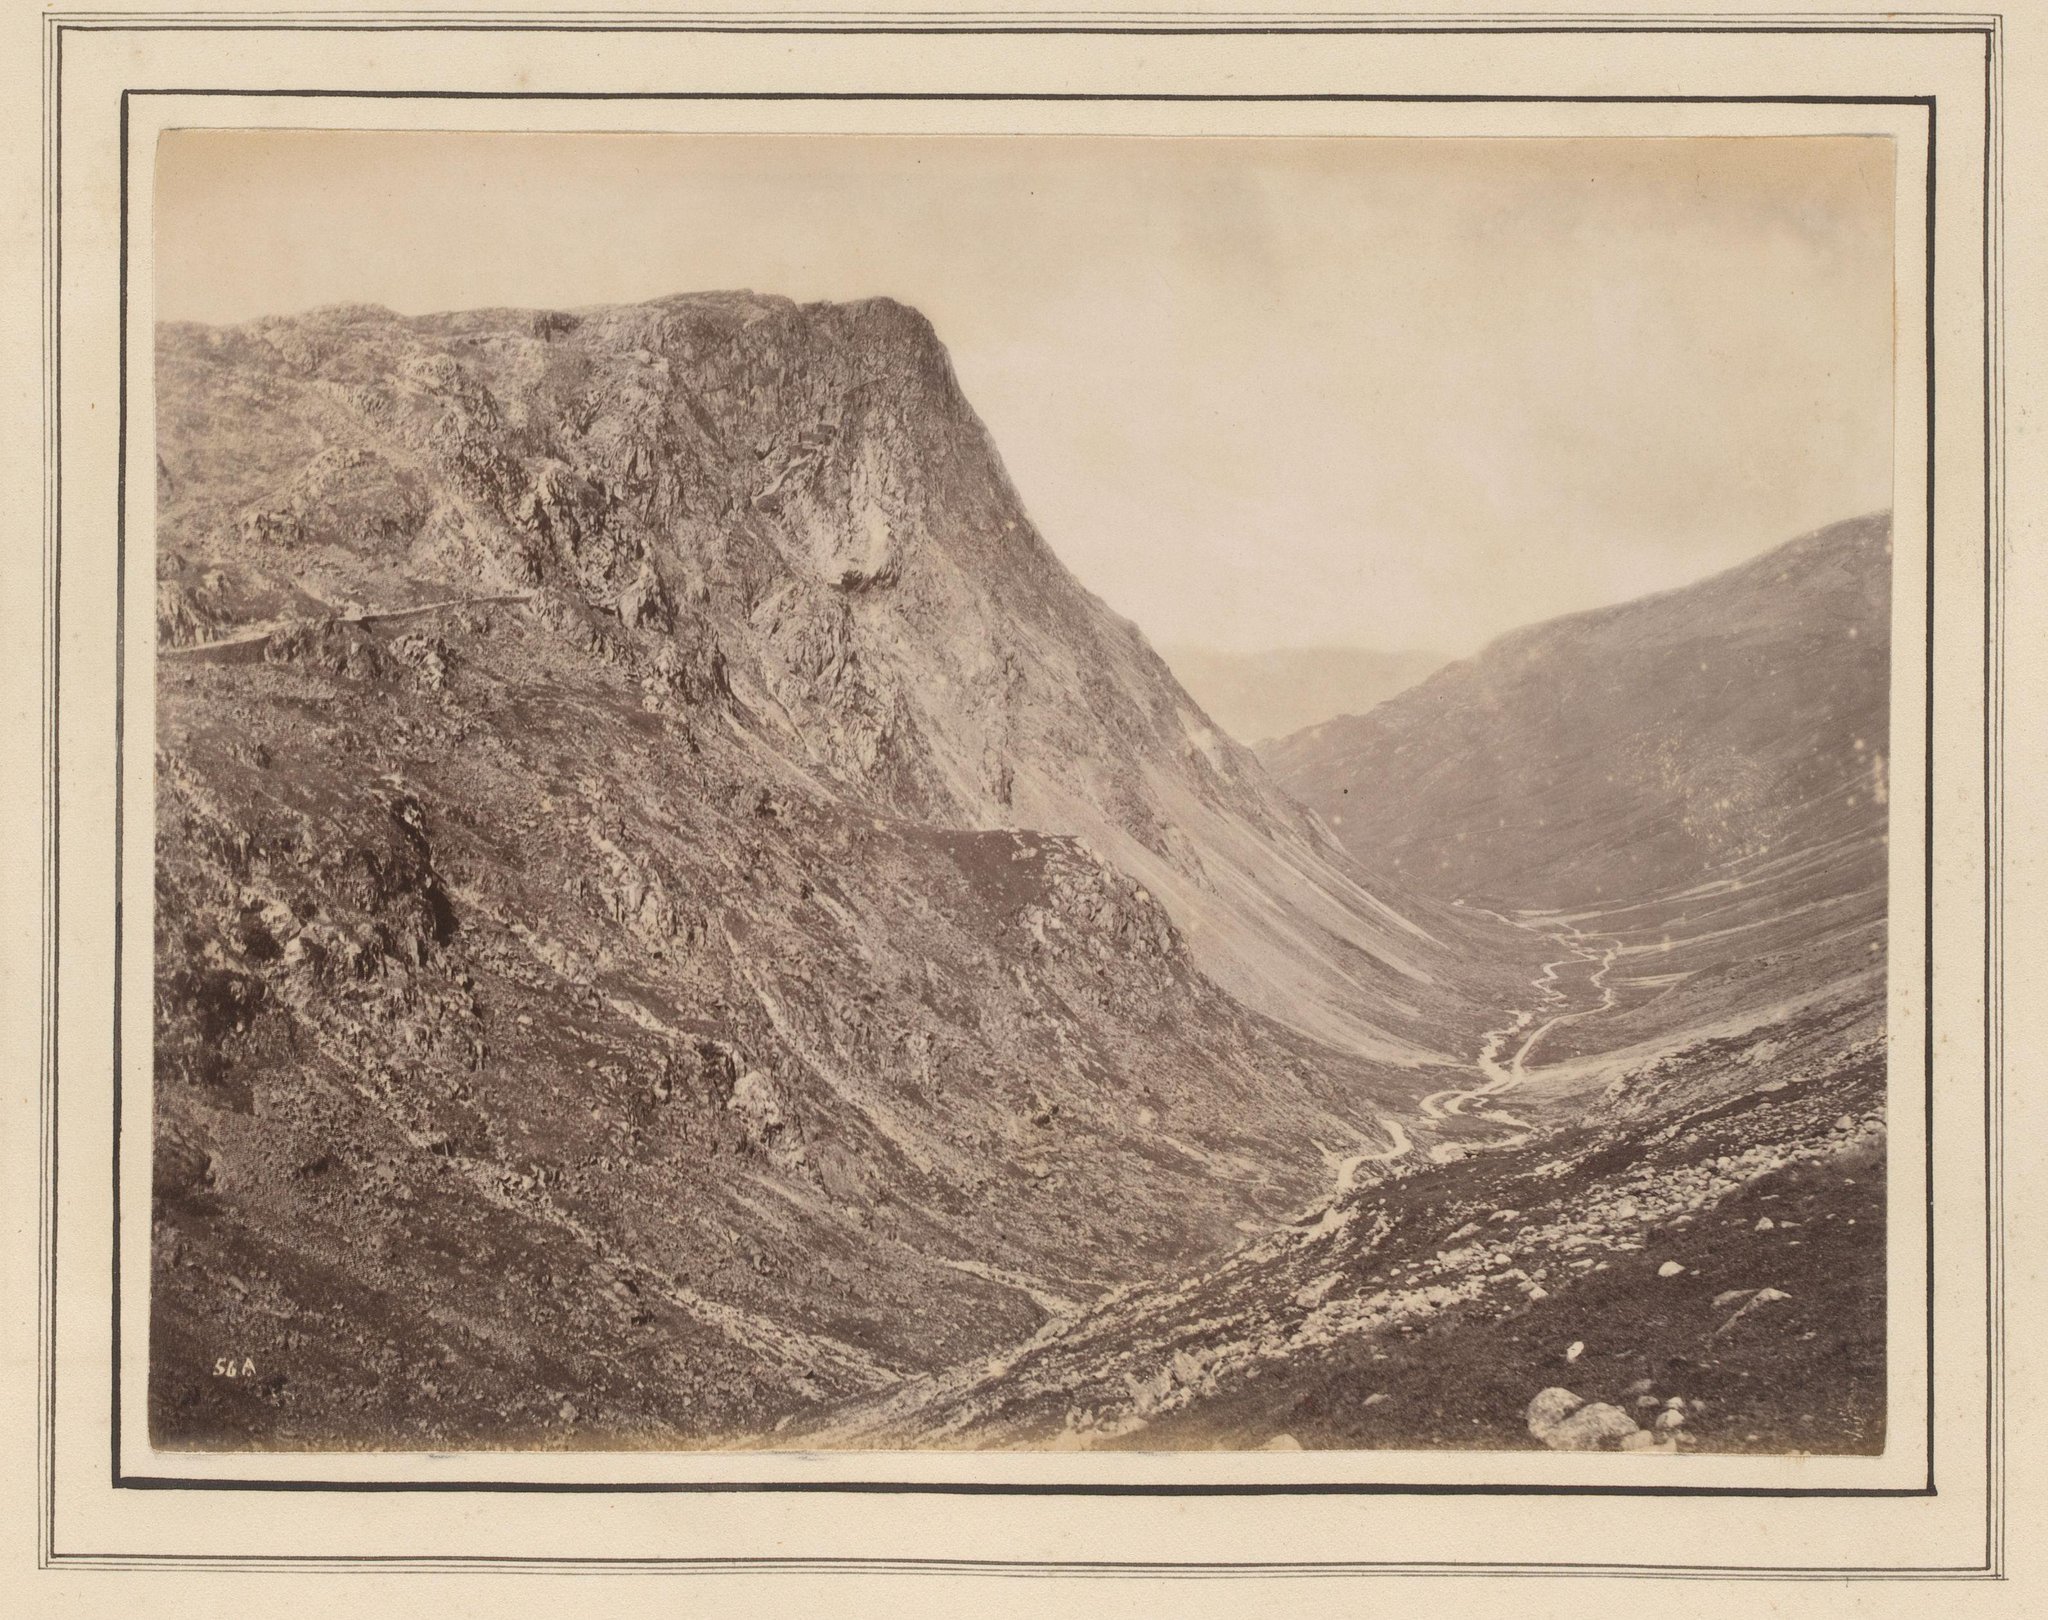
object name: photograph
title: Lakes of England. Honester Pass.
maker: Anonymous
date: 1870-1890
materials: paper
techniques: albumen print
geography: lake district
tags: dale, valley, mountains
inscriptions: number: ‘56 A’